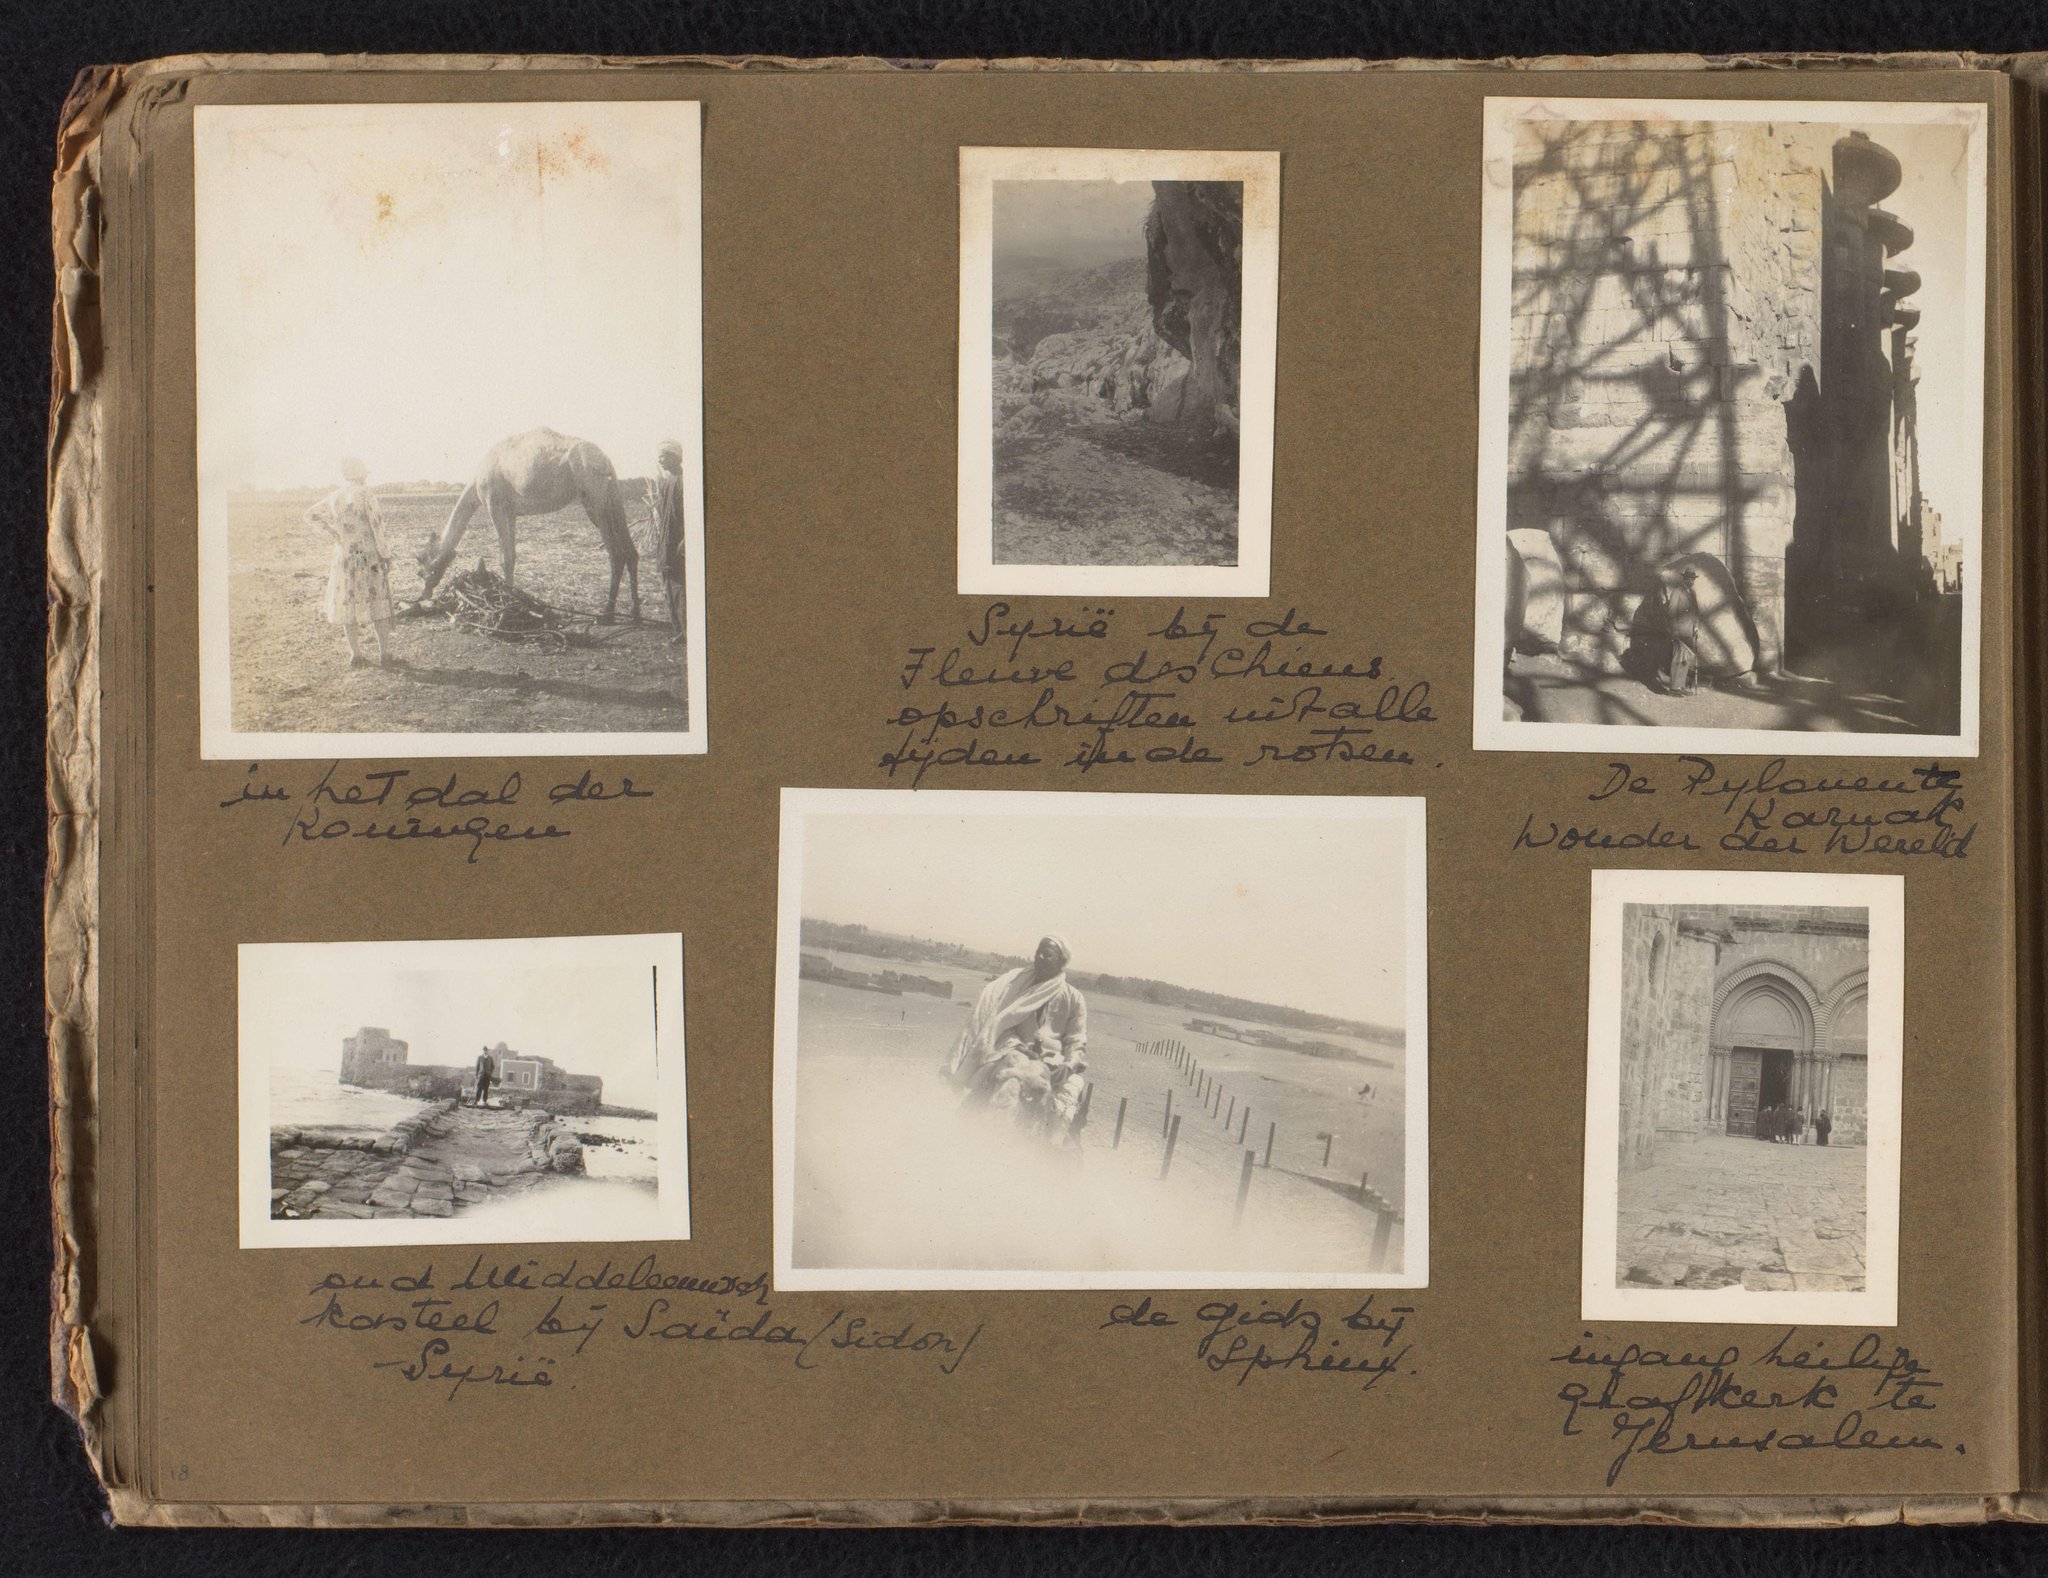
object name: album leaf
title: Zes foto's van een reis naar Egypte, Syrië en Jeruzalem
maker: carolina frederika onnen (lien/loen)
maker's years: 1896-1983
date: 1903-1927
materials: paper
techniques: gelatin silver print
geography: middle east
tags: the hague, hoofed animals: camel, temple, shrine ~ egyptian religion, church (exterior), rock-formations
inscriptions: inscription: ‘in het dal der/ koningen’, inscription: ‘Syrië bij de/ Fleuve des Chiens/ opschriften uit alle/ tijden in de rotsen’, inscription: ‘de gids bij/ Sphinx’, inscription: ‘oud Middeleeuwsch/ kasteel bij Saïda (Sidon)/ Syrië’, inscription: ‘ingang heilige/ grafkerk te/ Jerusalem’, inscription: ‘De Pylaren te/ Karnak/ Wonder der Wereld’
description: Deze foto's maken deel uit van een album.